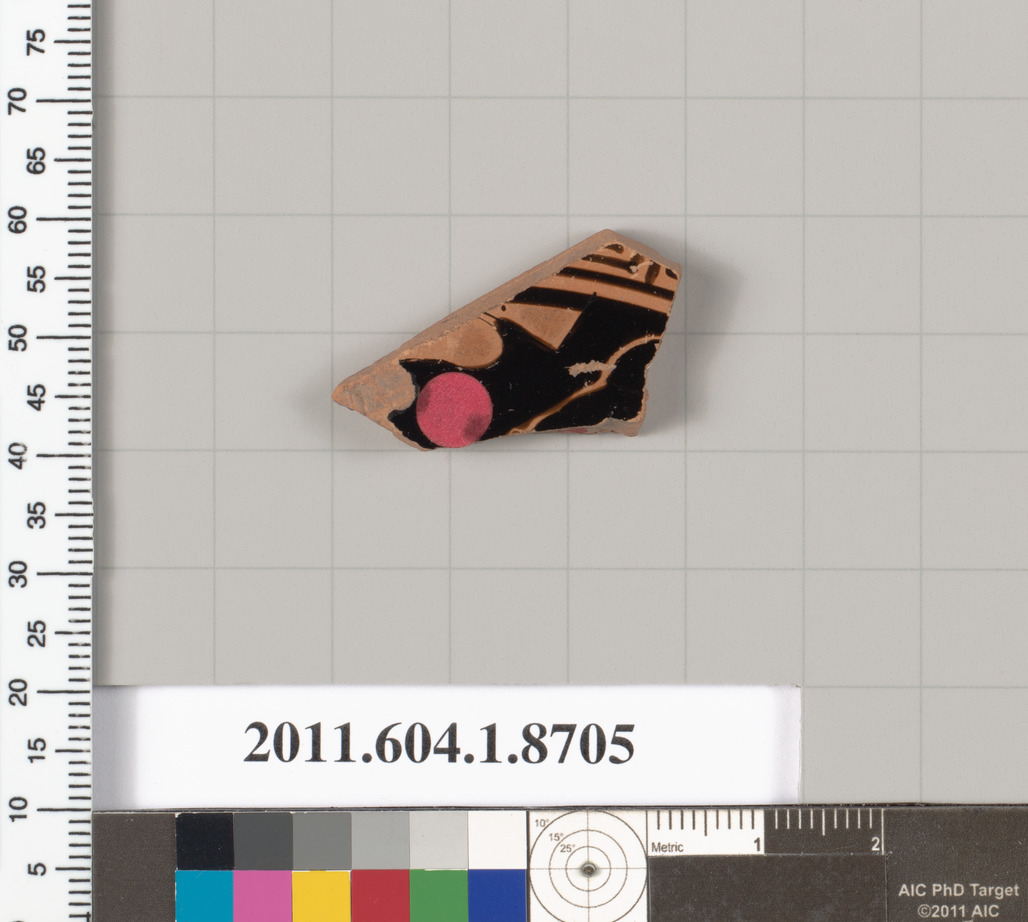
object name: kylix fragment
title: Terracotta fragment of a kylix (drinking cup)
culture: greek, attic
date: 490-480 BCE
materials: terracotta